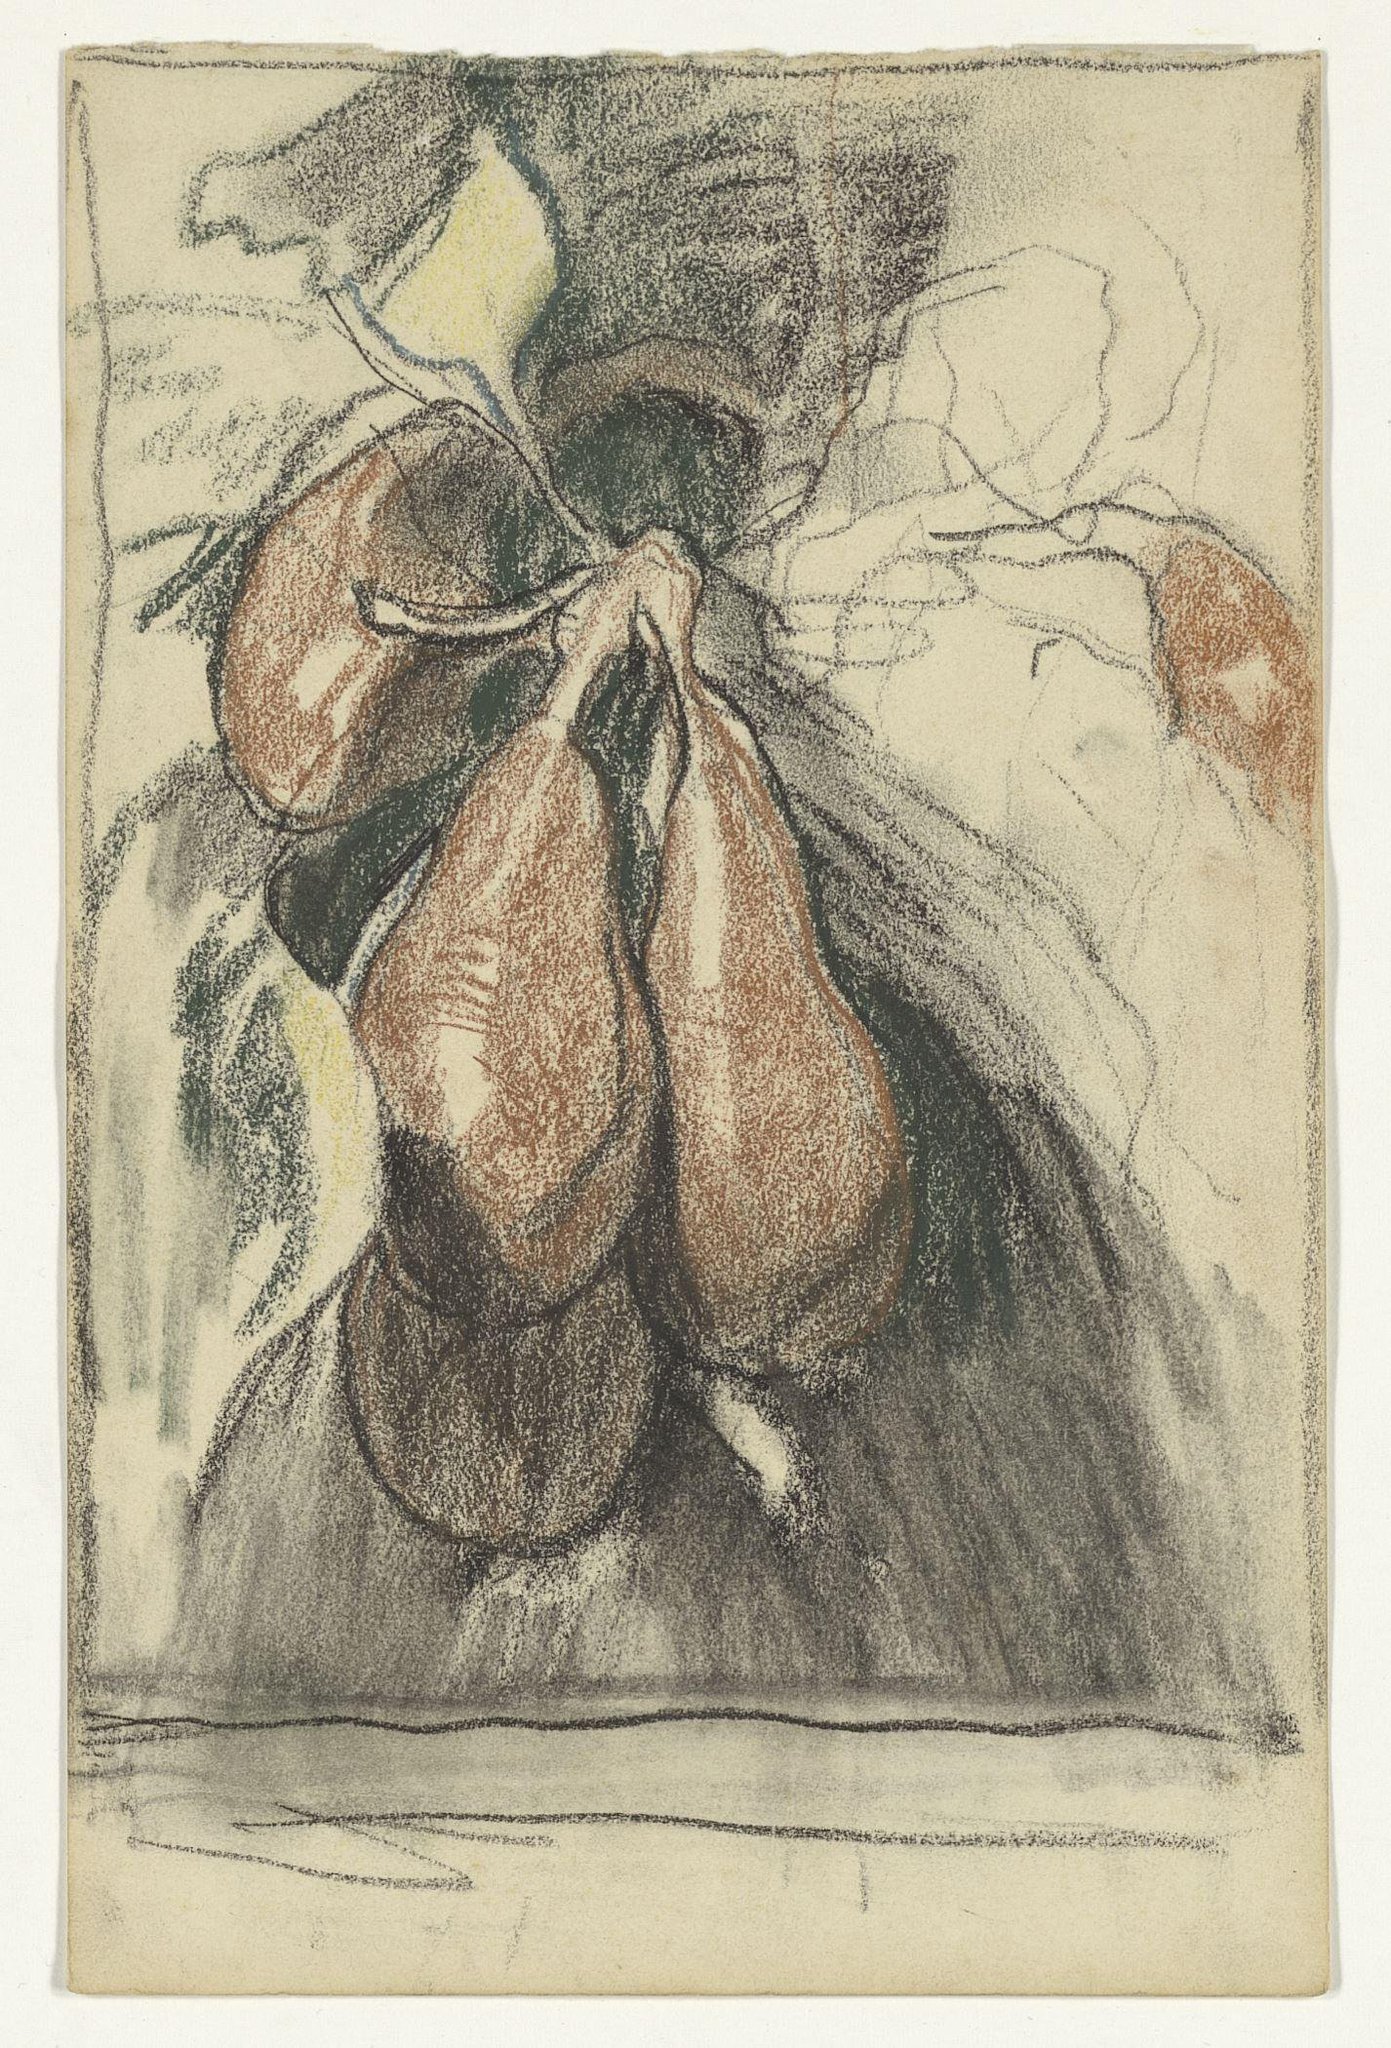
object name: drawing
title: Kalebasperen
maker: jac van looij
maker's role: draughtsman, painter, print maker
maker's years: 1855-1930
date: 1920-1924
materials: chalk, paper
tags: fruits: pear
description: De huidige titel is door het Rijksmuseum overgenomen van het Instituut Collectie Nederland.